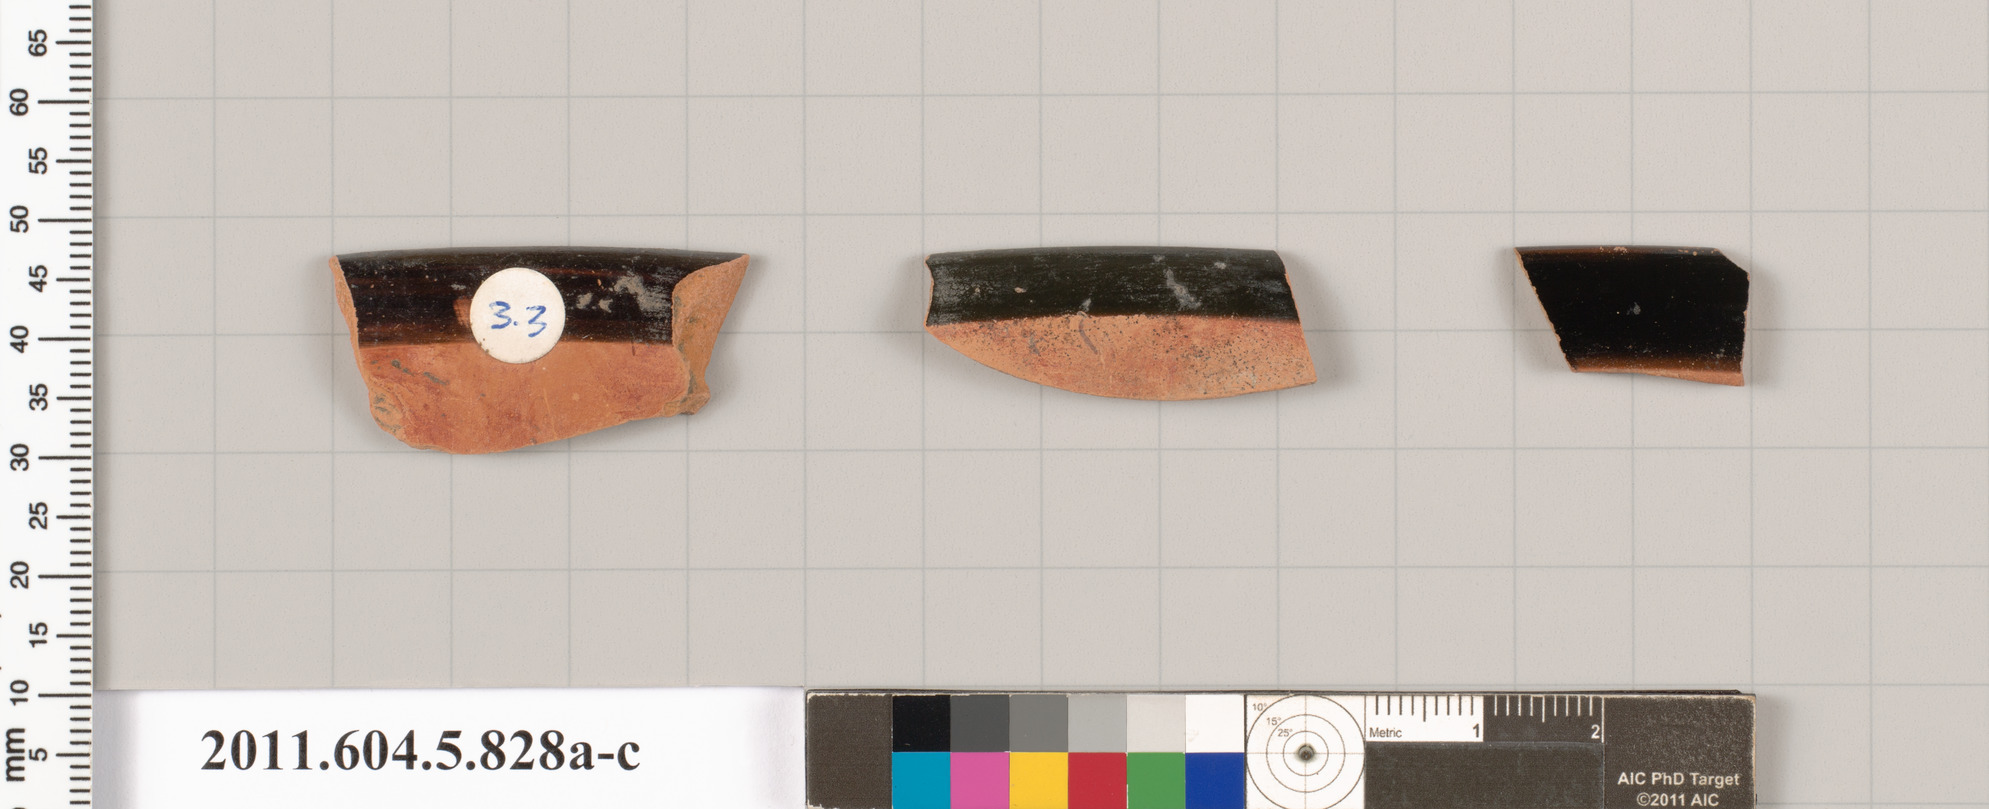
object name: kylix fragment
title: Terracotta rim fragments of kylikes (drinking cups)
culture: greek, attic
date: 600-401 BCE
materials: terracotta